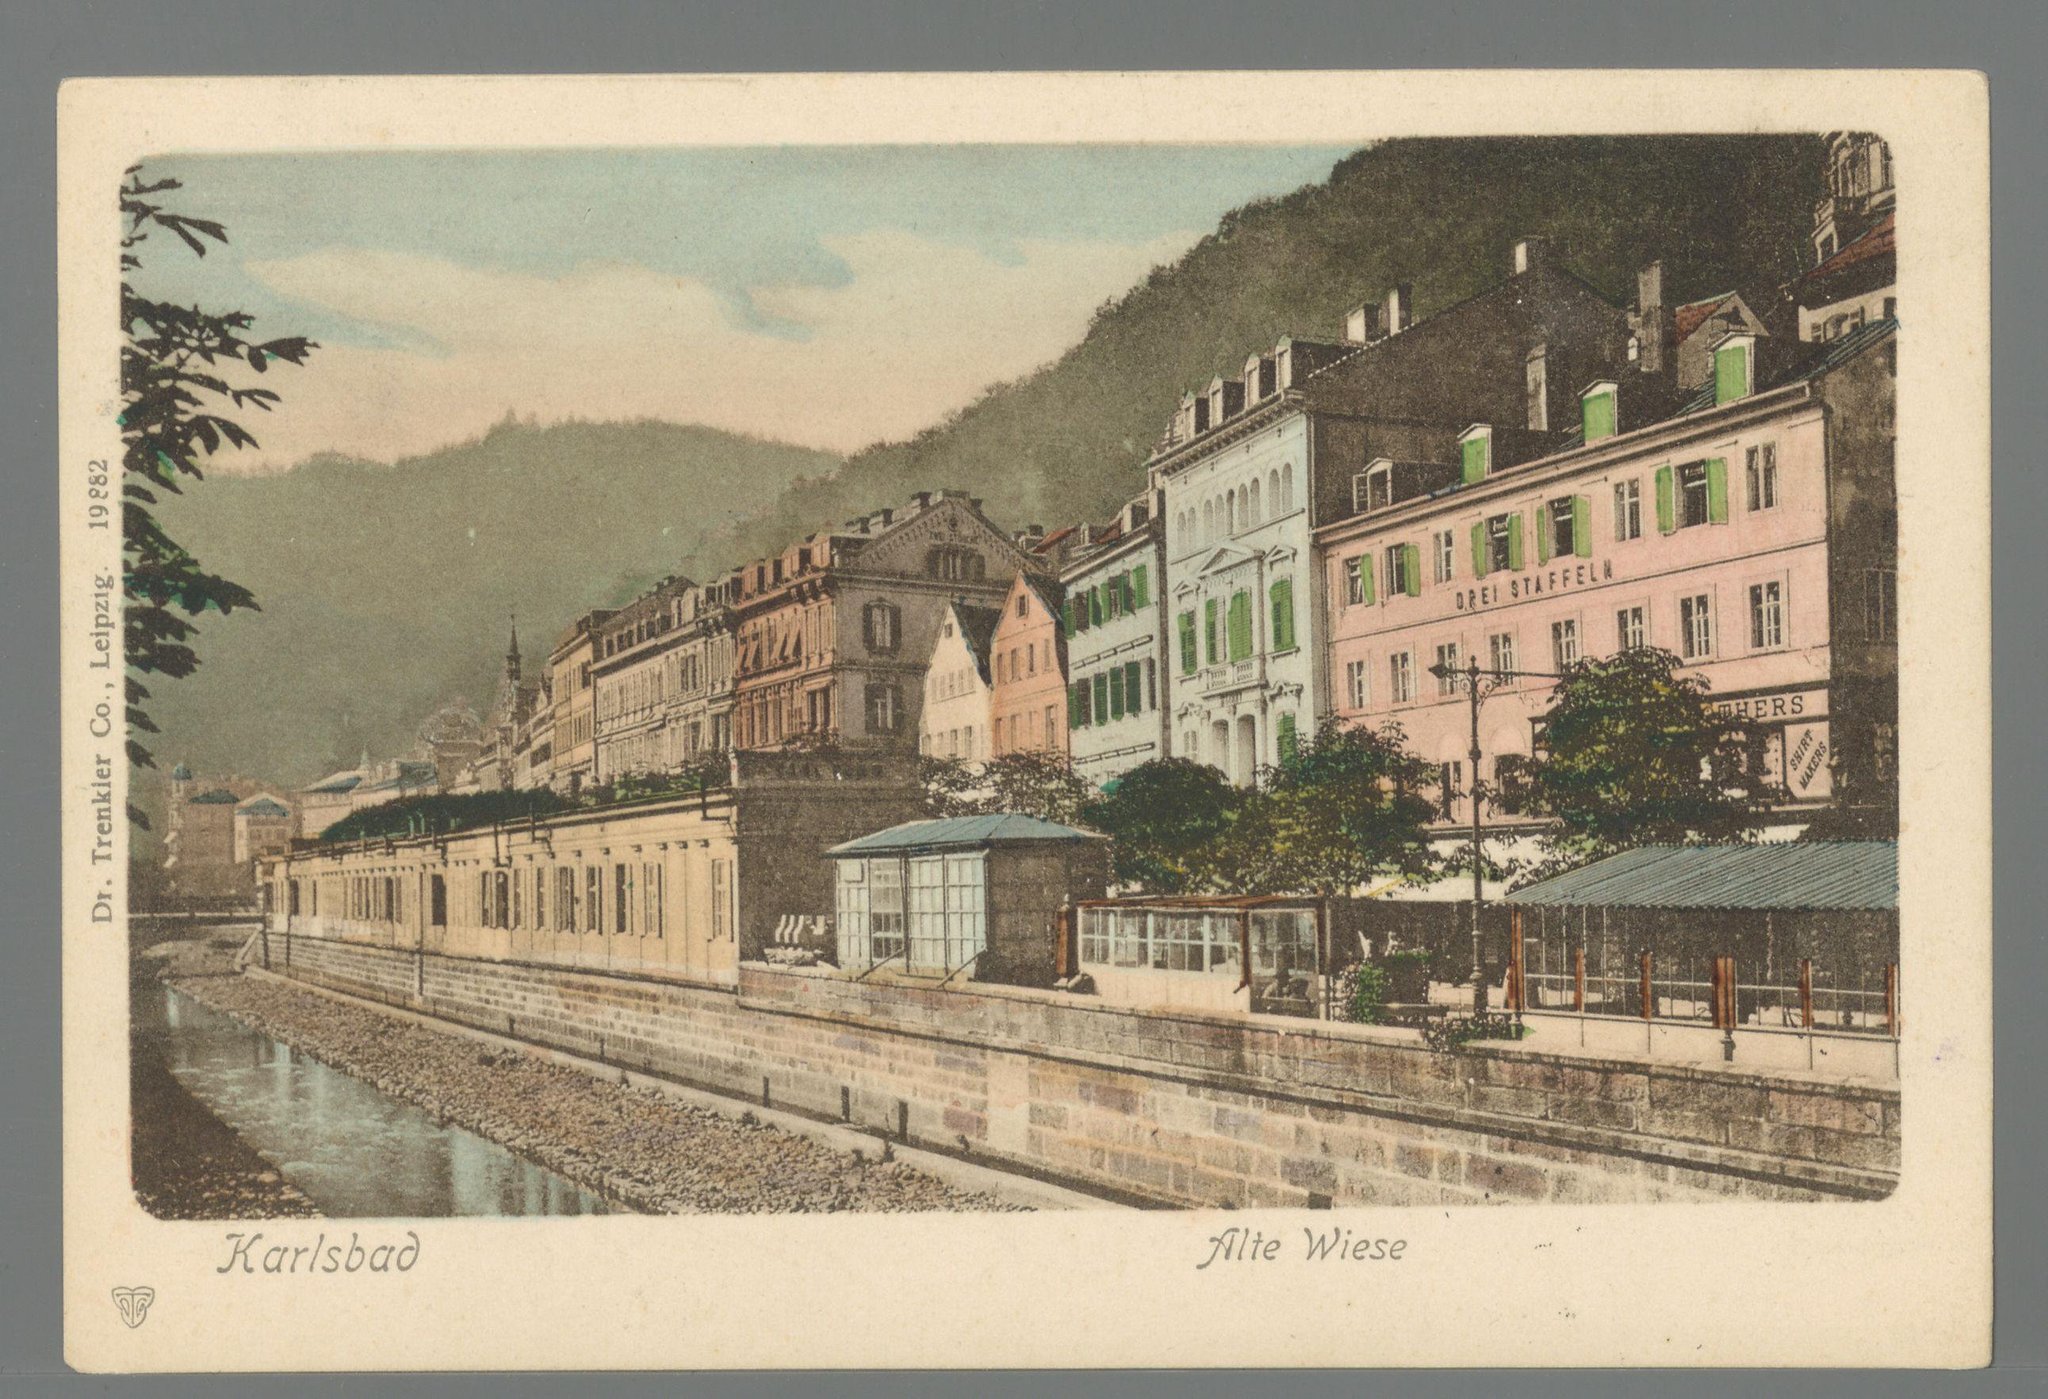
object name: photomechanical print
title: Karlsbad. Alte Wiese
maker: Anonymous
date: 1894-1903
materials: cardboard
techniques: photograph, lithograph, writing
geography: leipzig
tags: street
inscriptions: postage stamp